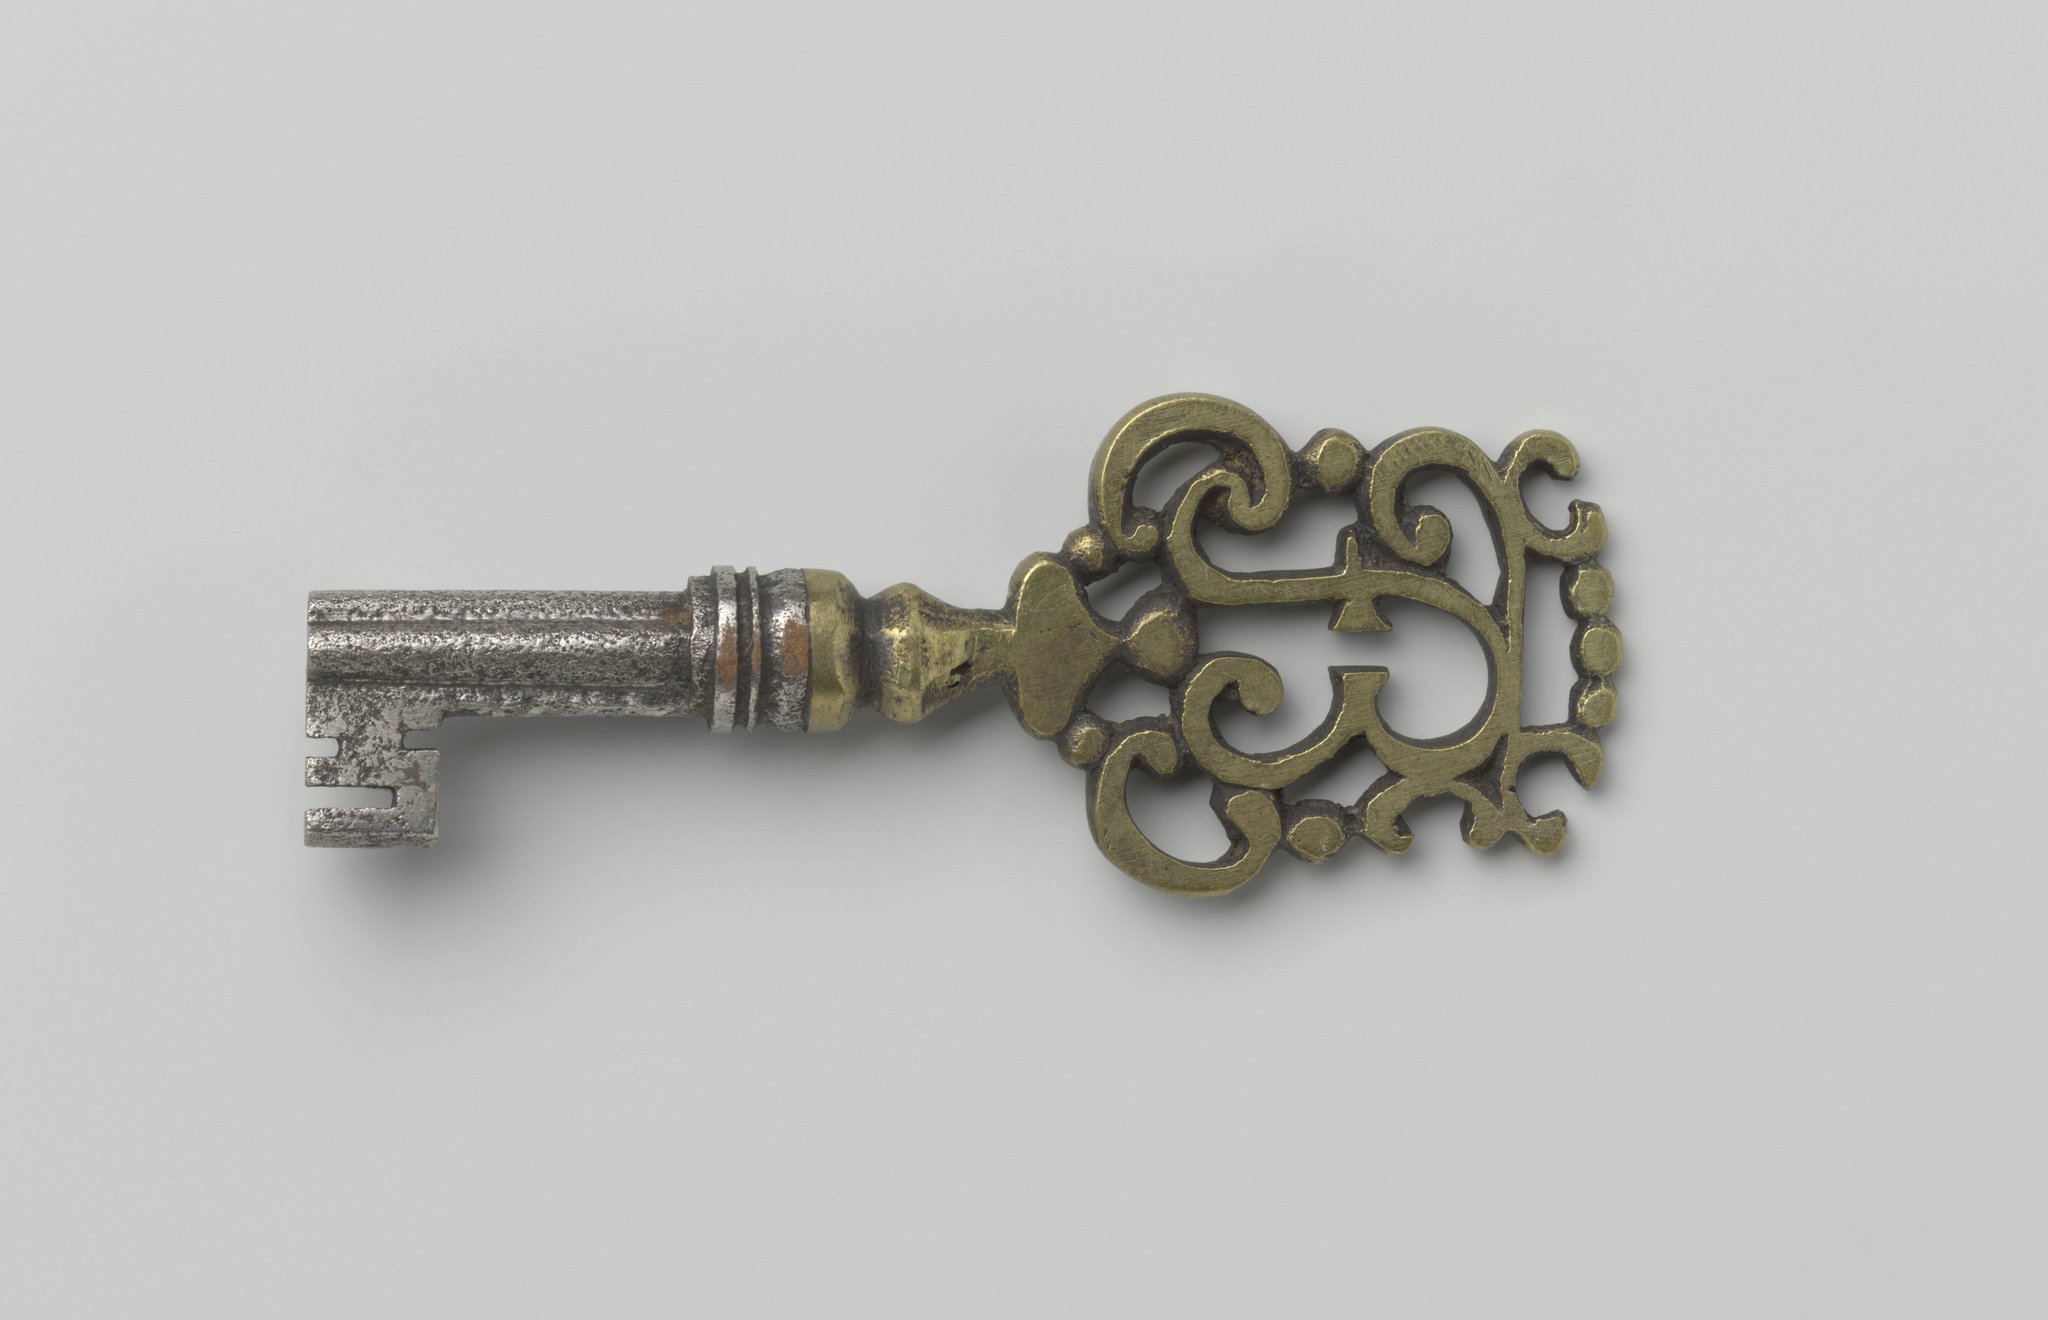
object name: pipe key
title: Pijpsleutel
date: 1700-1800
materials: copper, iron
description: Pijpsleutel waarvan de greep gevormd wordt door het monogram F.B. De klaverbladvormige schacht is kruisvormig geboord. Greep van koper, schacht en baard van ijzer.